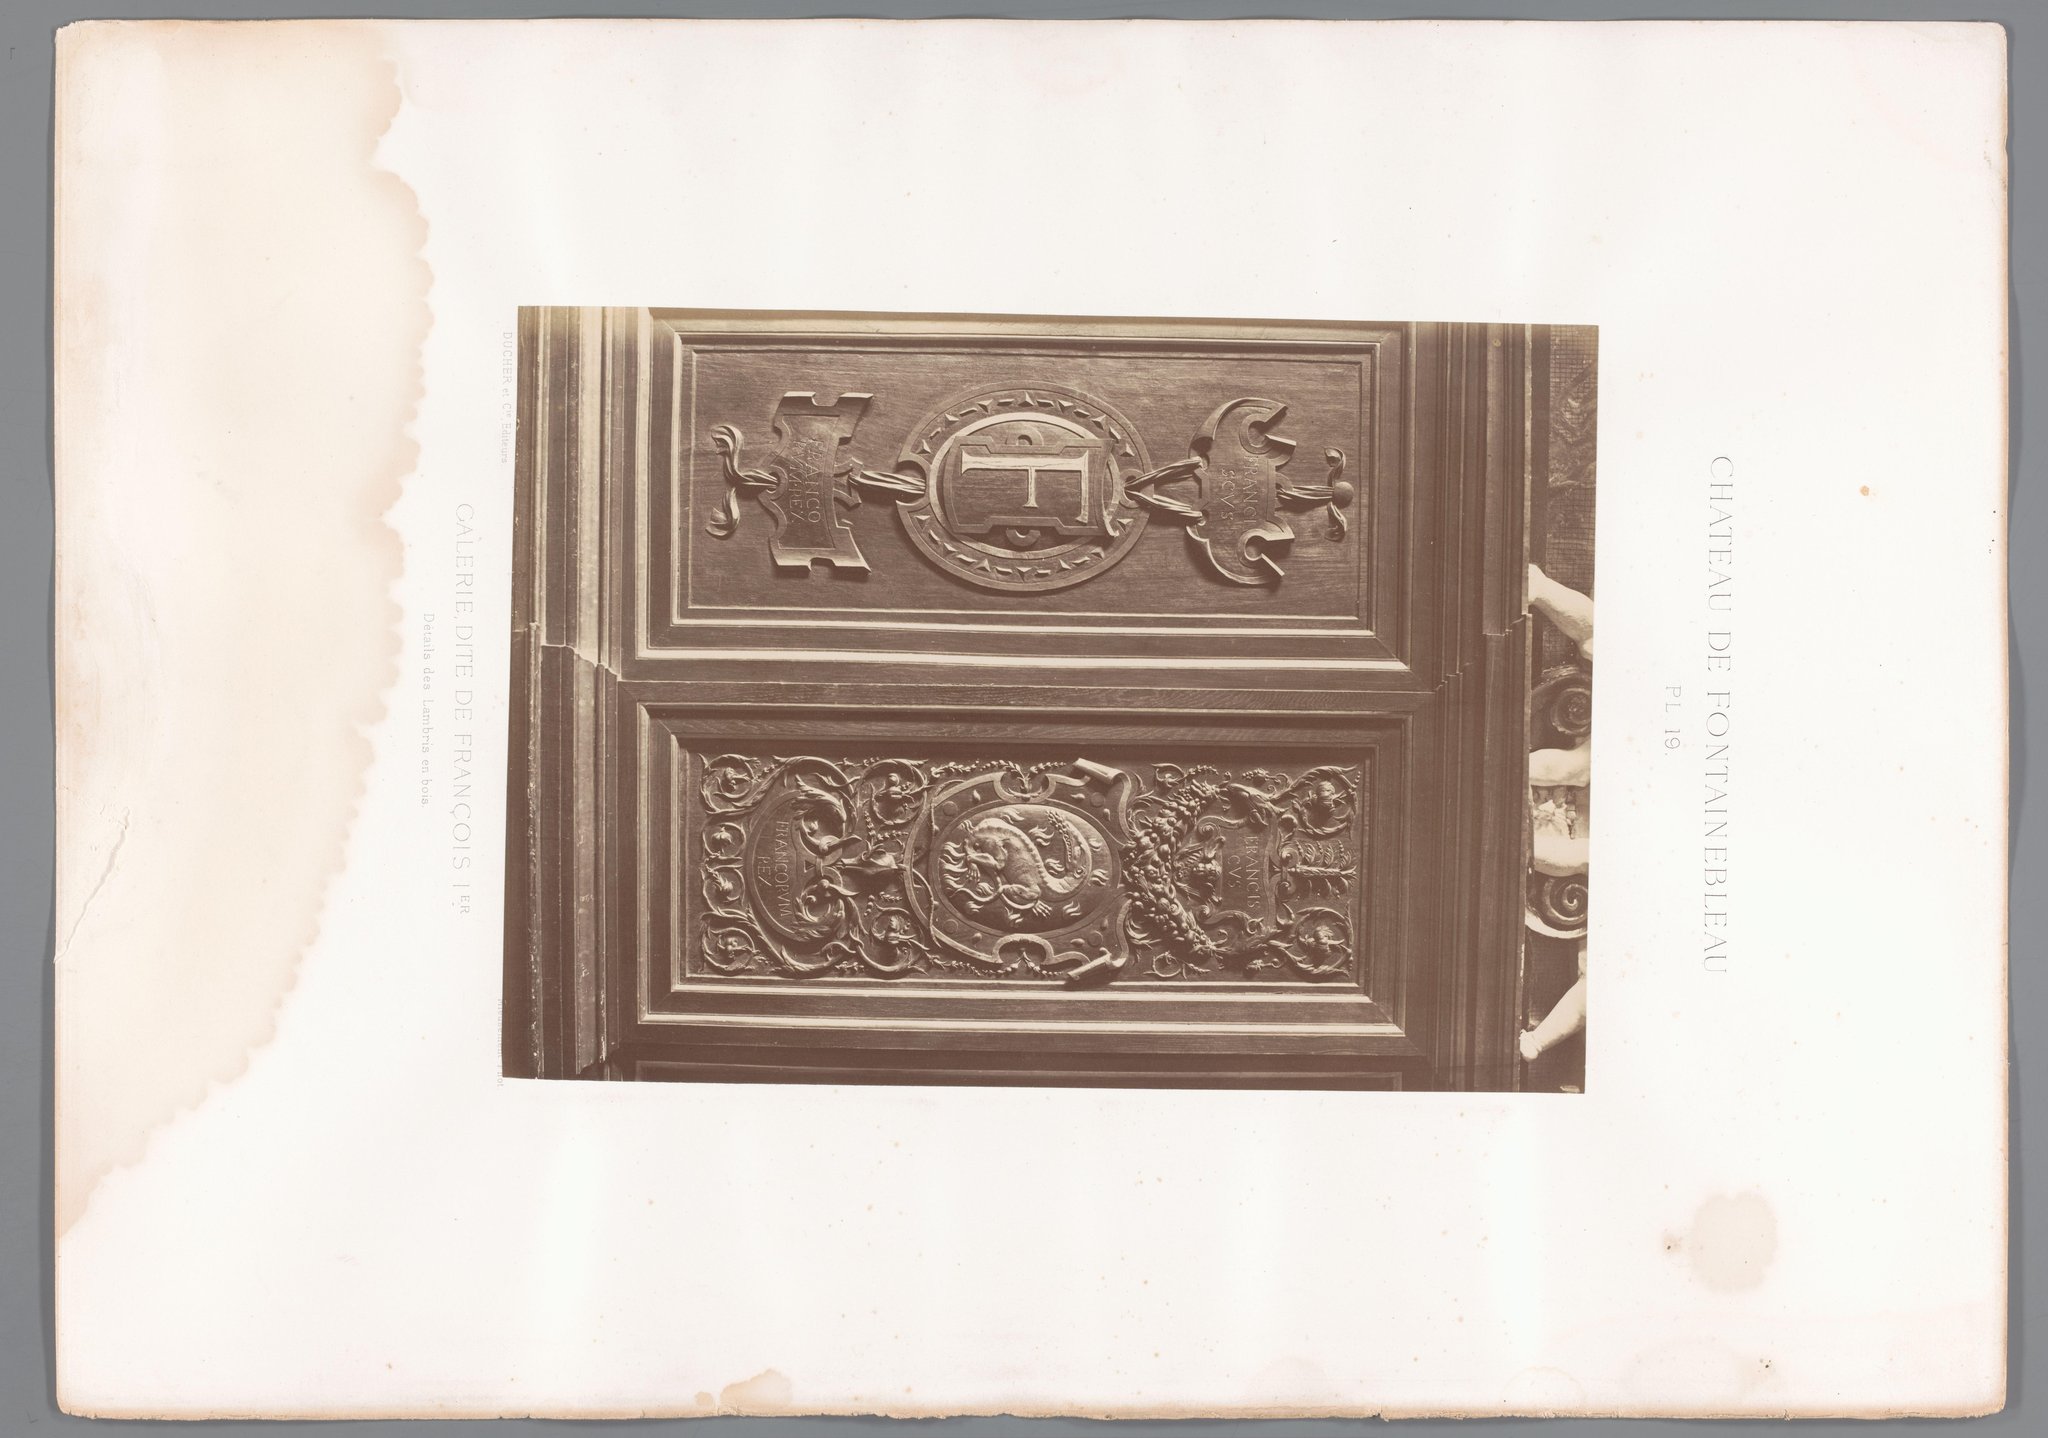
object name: photograph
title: Chateau de Fontainebleau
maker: séraphin-médéric mieusement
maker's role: fotograaf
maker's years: 1840-1905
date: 1870-1875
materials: photographic support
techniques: albumen print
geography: fontainebleau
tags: castle - aa - civic architecture: inside, panelling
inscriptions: number: ‘PL. 19.’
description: Deze foto maakt deel uit van een omslag met dertig foto's en twee tekstbladen.